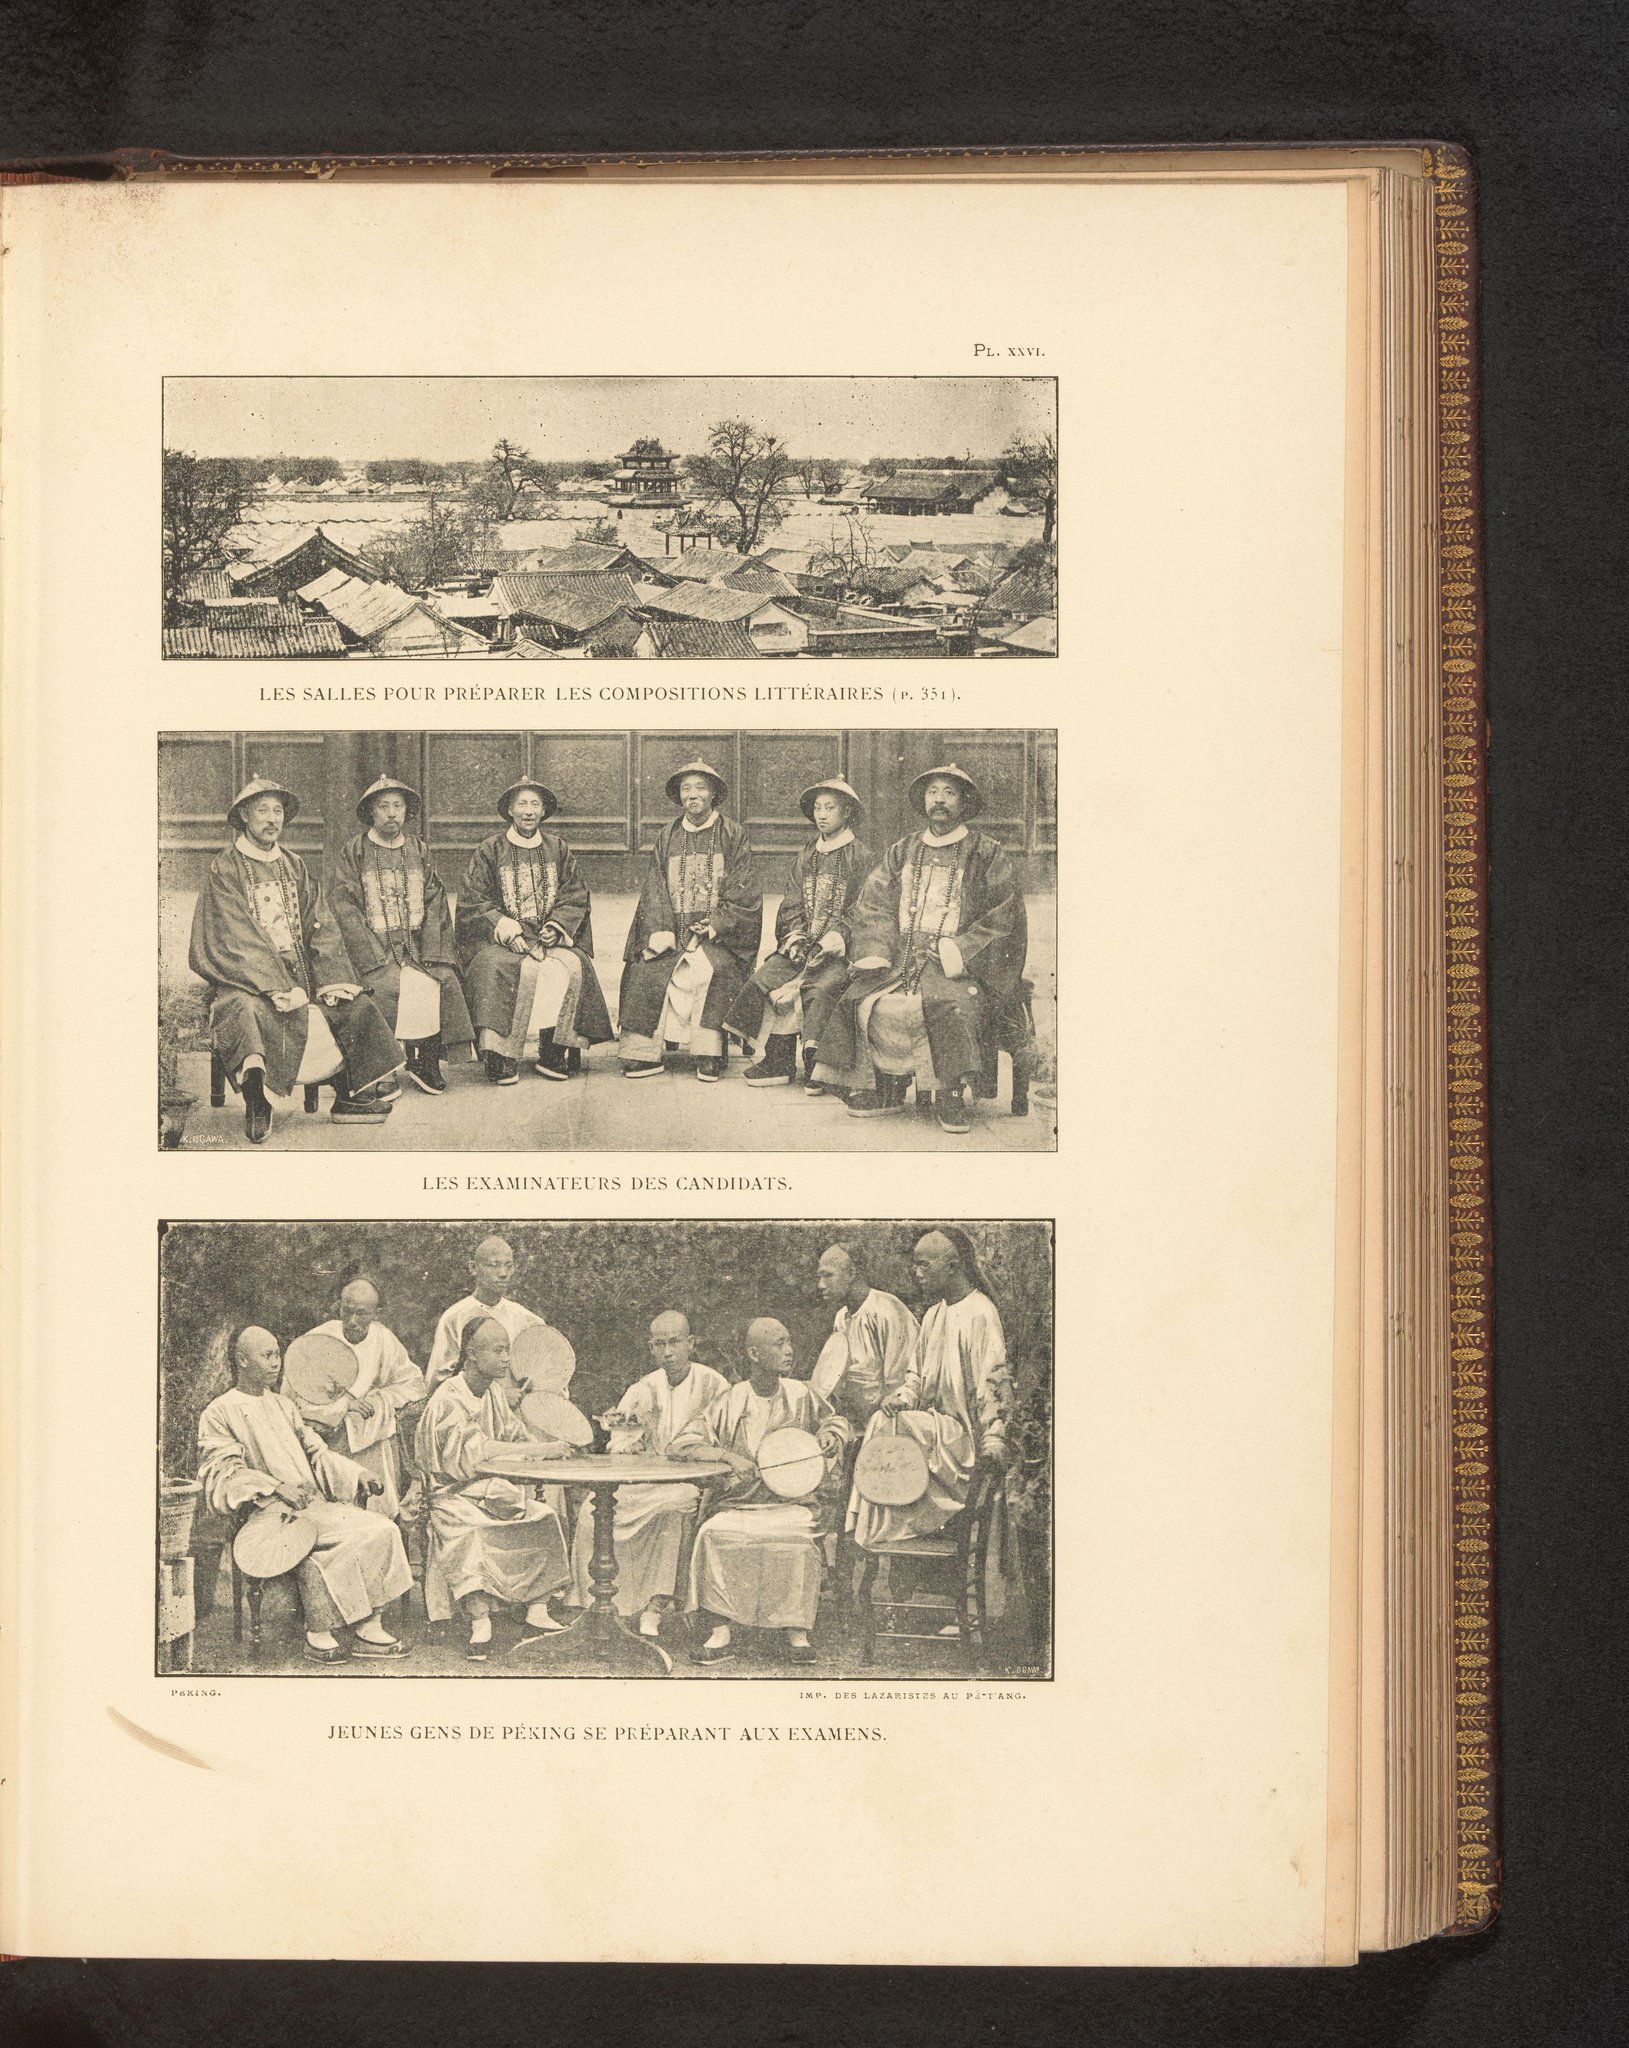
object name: page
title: Gezicht op daken, Groepsportret van examinatoren en Groepsportret van jongeren die zich op een examen voorbereiden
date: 1892-1897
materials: paper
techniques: autotype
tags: roof (of house or building), adult man, anonymous historical persons portrayed in a group, in a group-portrait